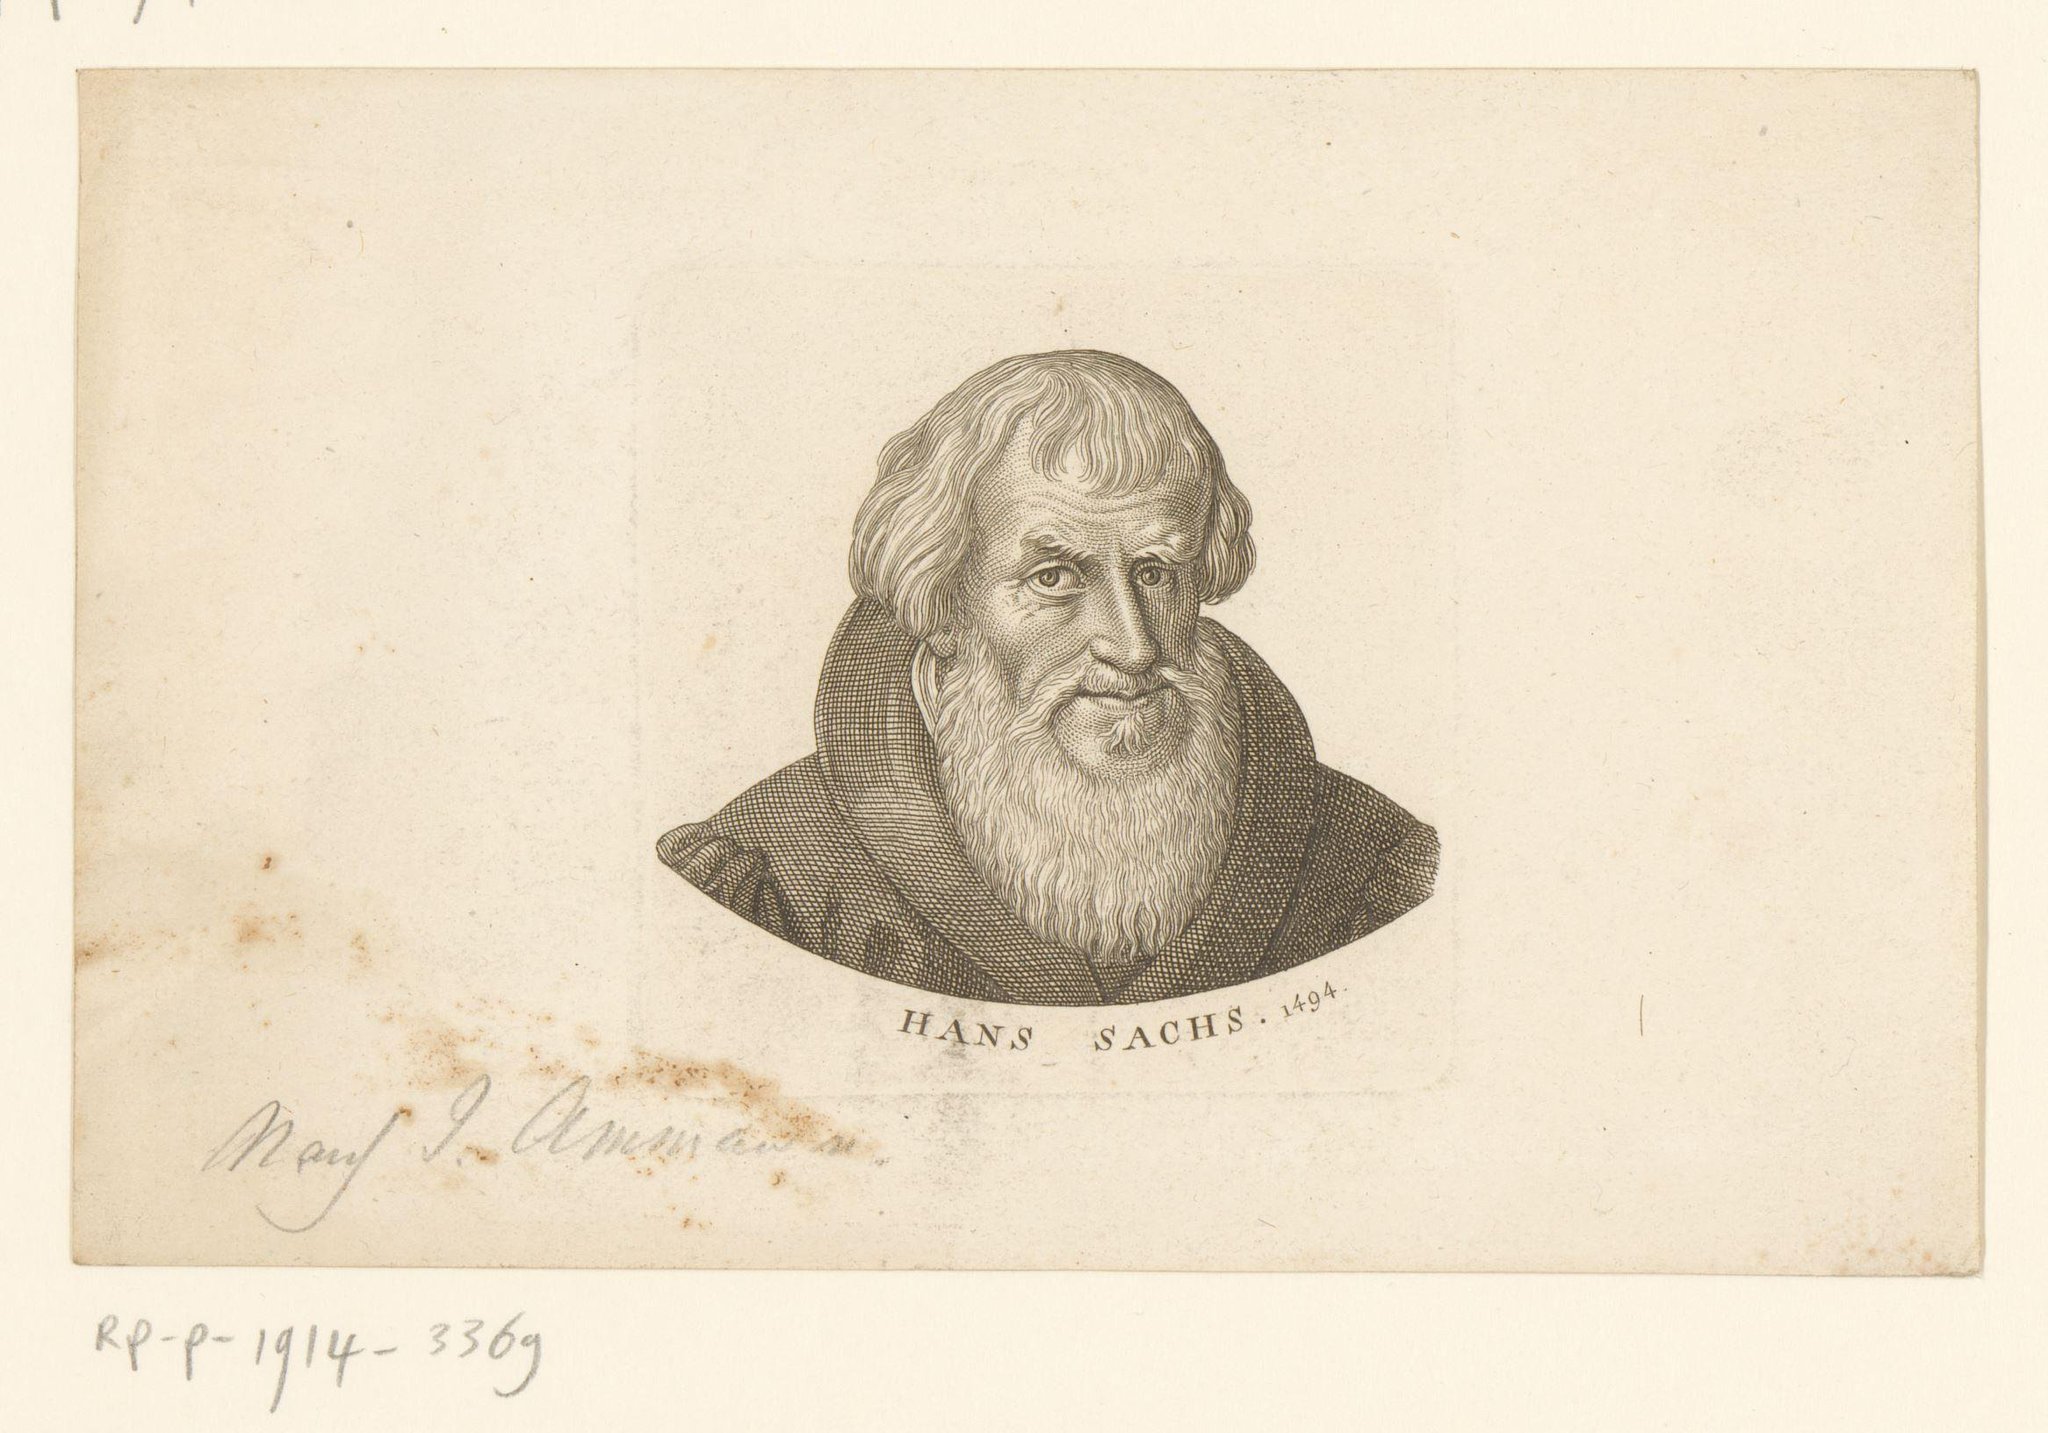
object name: print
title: Portret van Hans Sachs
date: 1775-1840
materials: paper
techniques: engraving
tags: hans sachs, historical persons, writer, poet, author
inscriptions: collector's mark: Lugt 2228, : ‘Nach J. Amman’